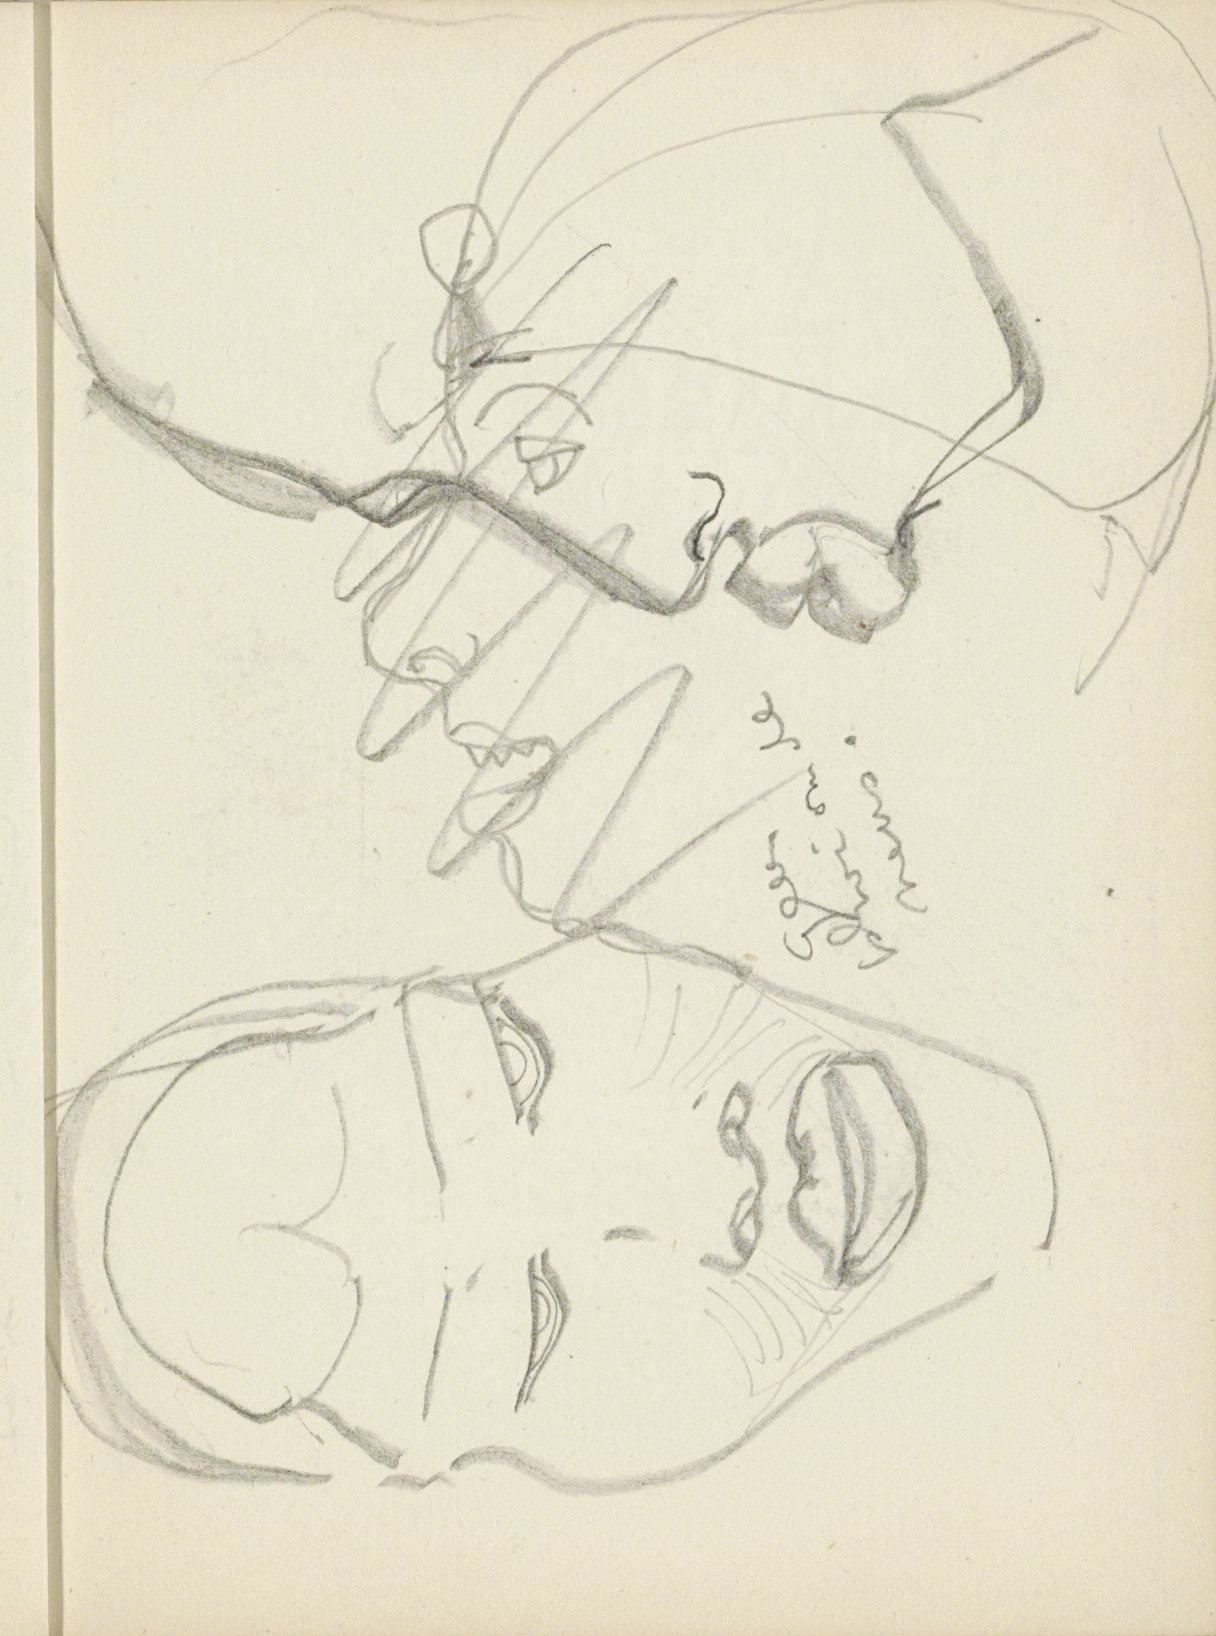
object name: sketchbook leaf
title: Portretten van twee Afrikanen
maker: reijer stolk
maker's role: draughtsman, print maker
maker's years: 1896-1945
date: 1916-1945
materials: paper, pencil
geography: africa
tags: head (human), africans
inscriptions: annotation: ‘geen/ plooi in de neus/ neus.’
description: Blad 15 recto uit een schetsboek met 60 bladen.